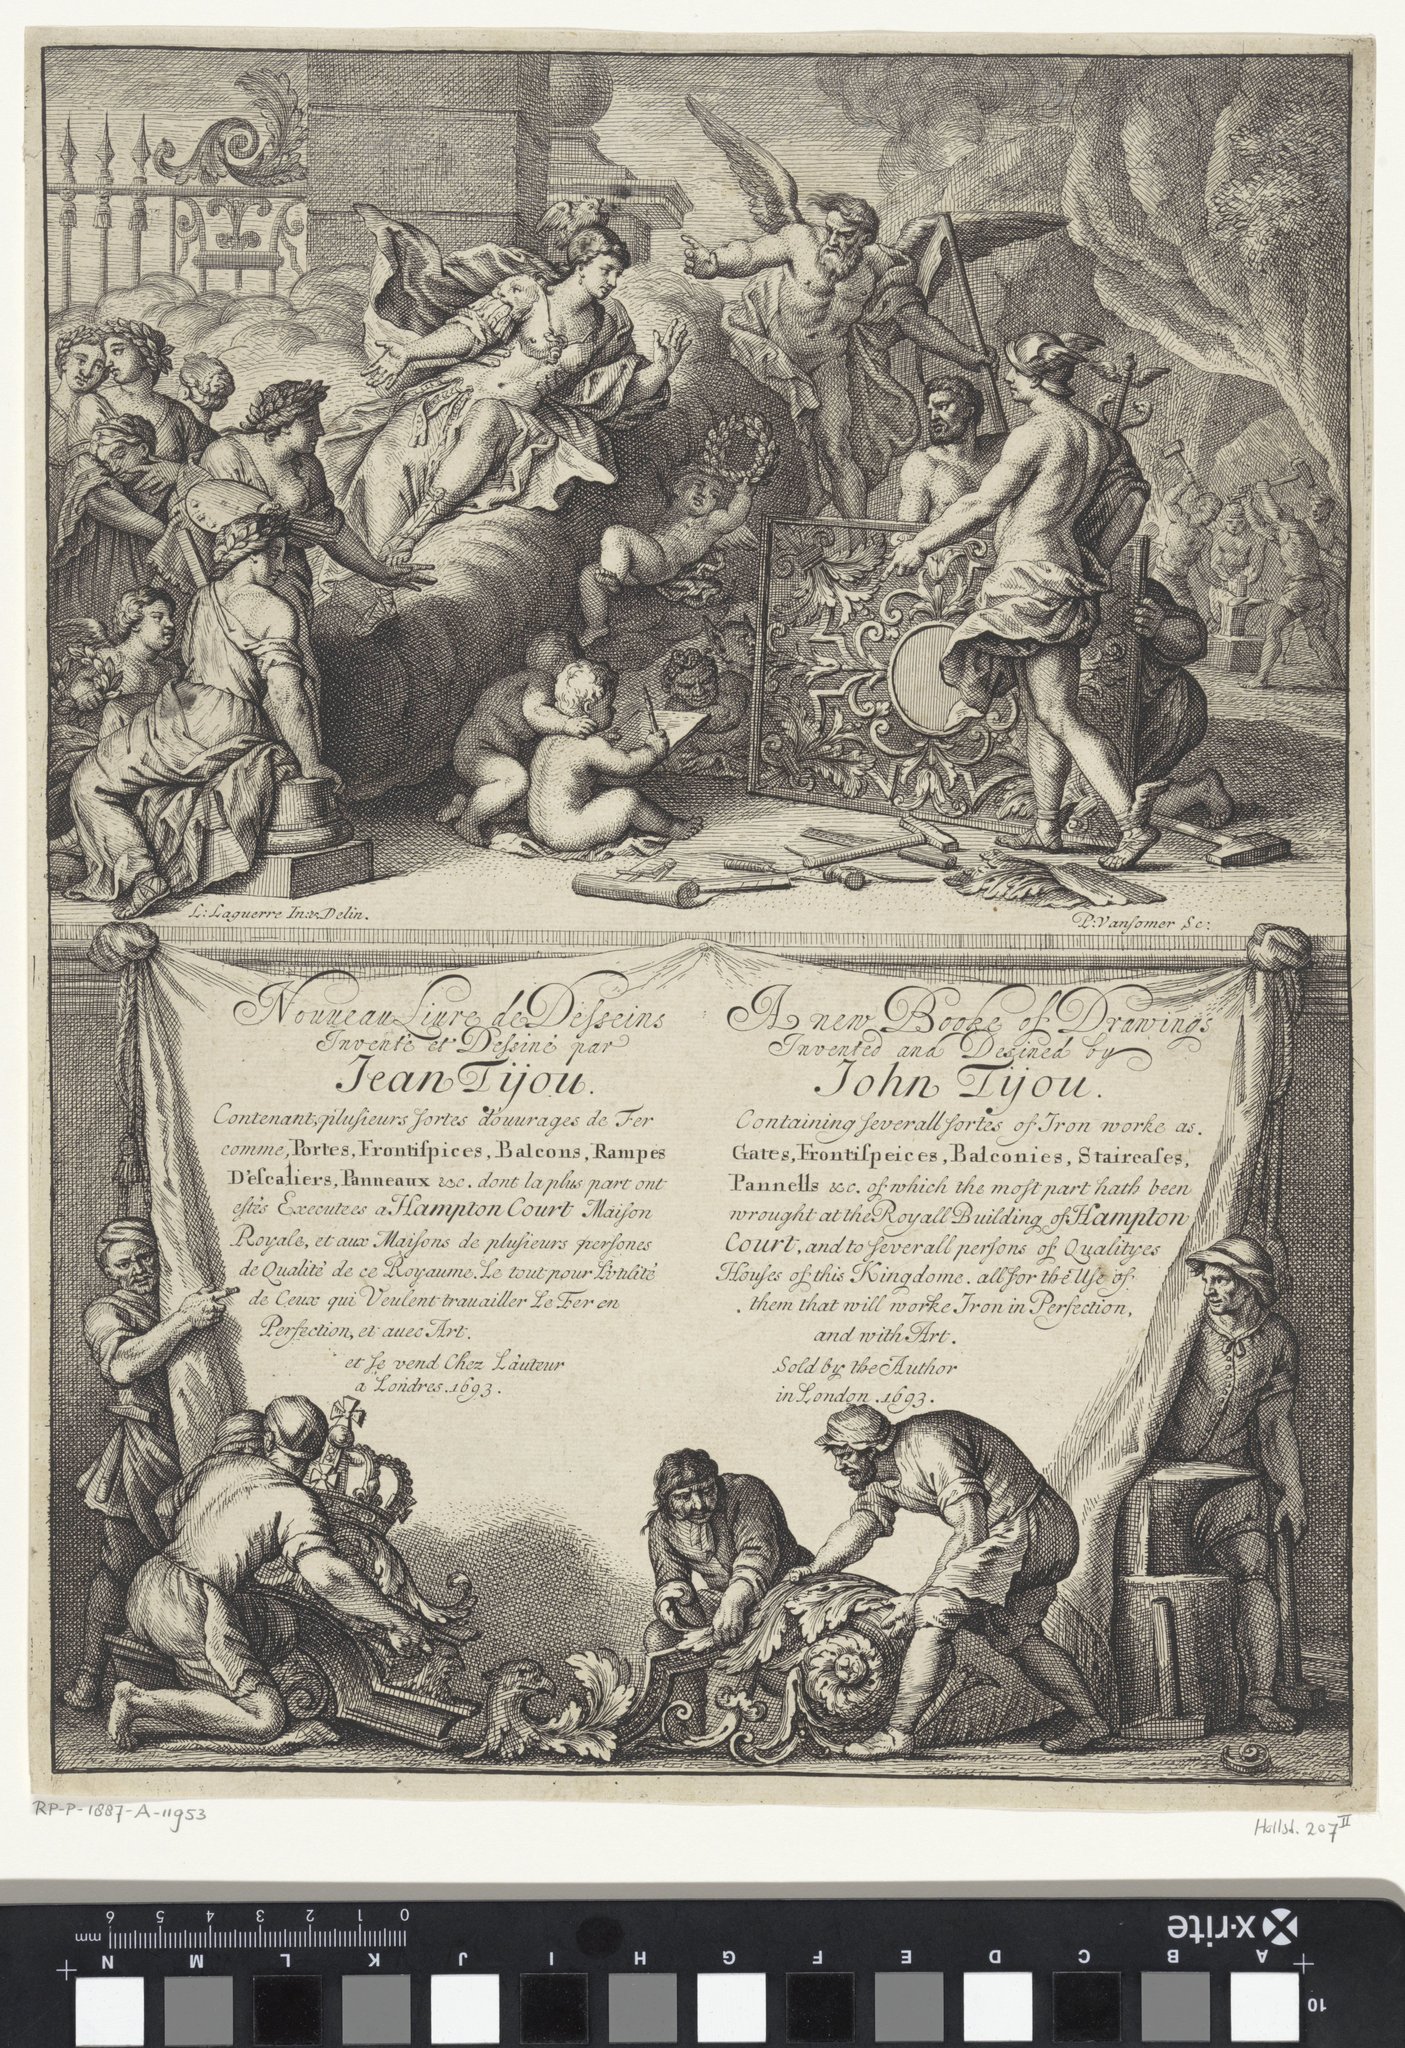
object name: print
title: Aanbieding van smeedwerk aan Minerva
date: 1693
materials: paper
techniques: engraving, etching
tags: minerva as patroness, applied arts, arts and crafts; industrial design, other scenes ~ vulcan forging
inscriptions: collector's mark: Lugt 2228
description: Vanaf een wolk bewondert Minerva een gesmeed ijzeren hek, dat Vulcanius en Mercurius haar tonen. De Tijd kijkt toe. Op de achtergrond een smidse in een grot.De vrouwen links van Minerva stellen de Schone kunsten voor. Onder deze voorstelling een tweede afbeelding, waarop mannen bezig zijn met het bekijken of herschikken van ornamenten. Daarboven hangt een draperie, waarop in het Frans en Engels de titel, auteur en inhoud van het boek staat weergegeven.